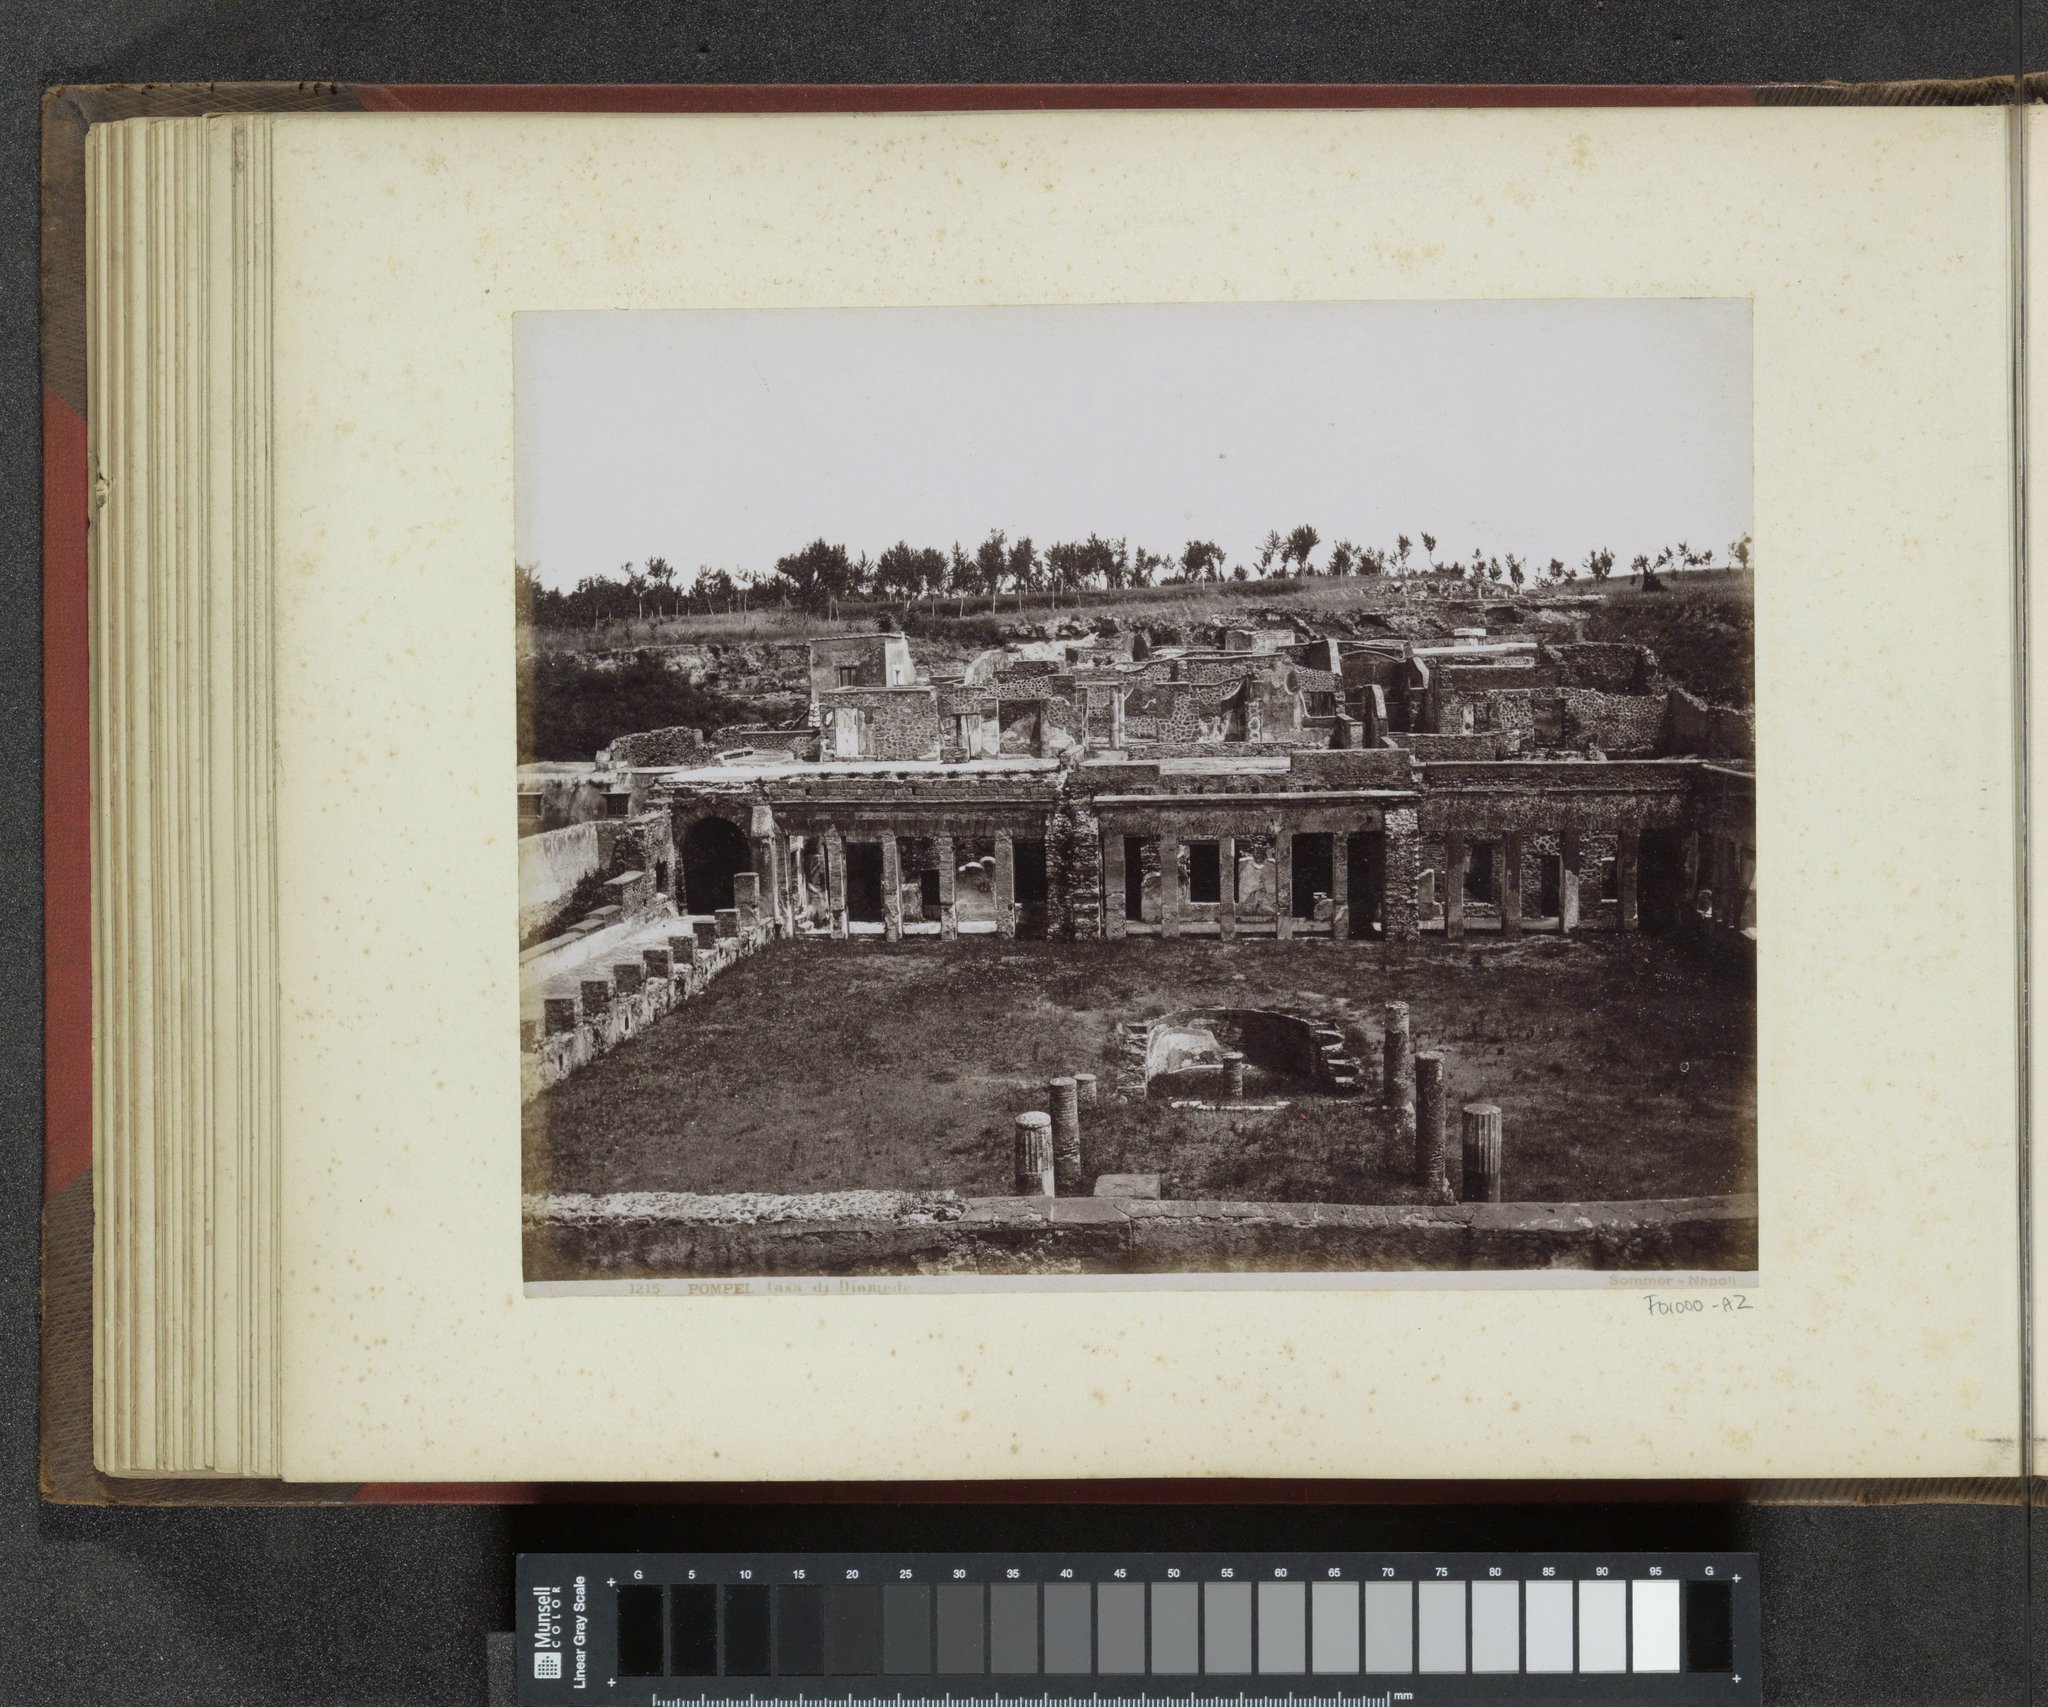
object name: photograph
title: Huis van Diomedes in Pompeï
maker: giorgio sommer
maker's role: fotograaf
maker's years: 1834-1914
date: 1870-1900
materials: paper, photographic support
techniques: albumen print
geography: pompeii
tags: excavation ~ archaeology, ruin of a dwelling, house, castle, etc., pompeii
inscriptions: negative number: ‘1215’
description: Onderdeel van Reisalbum met foto's van bezienswaardigheden in Italië en Frankrijk.